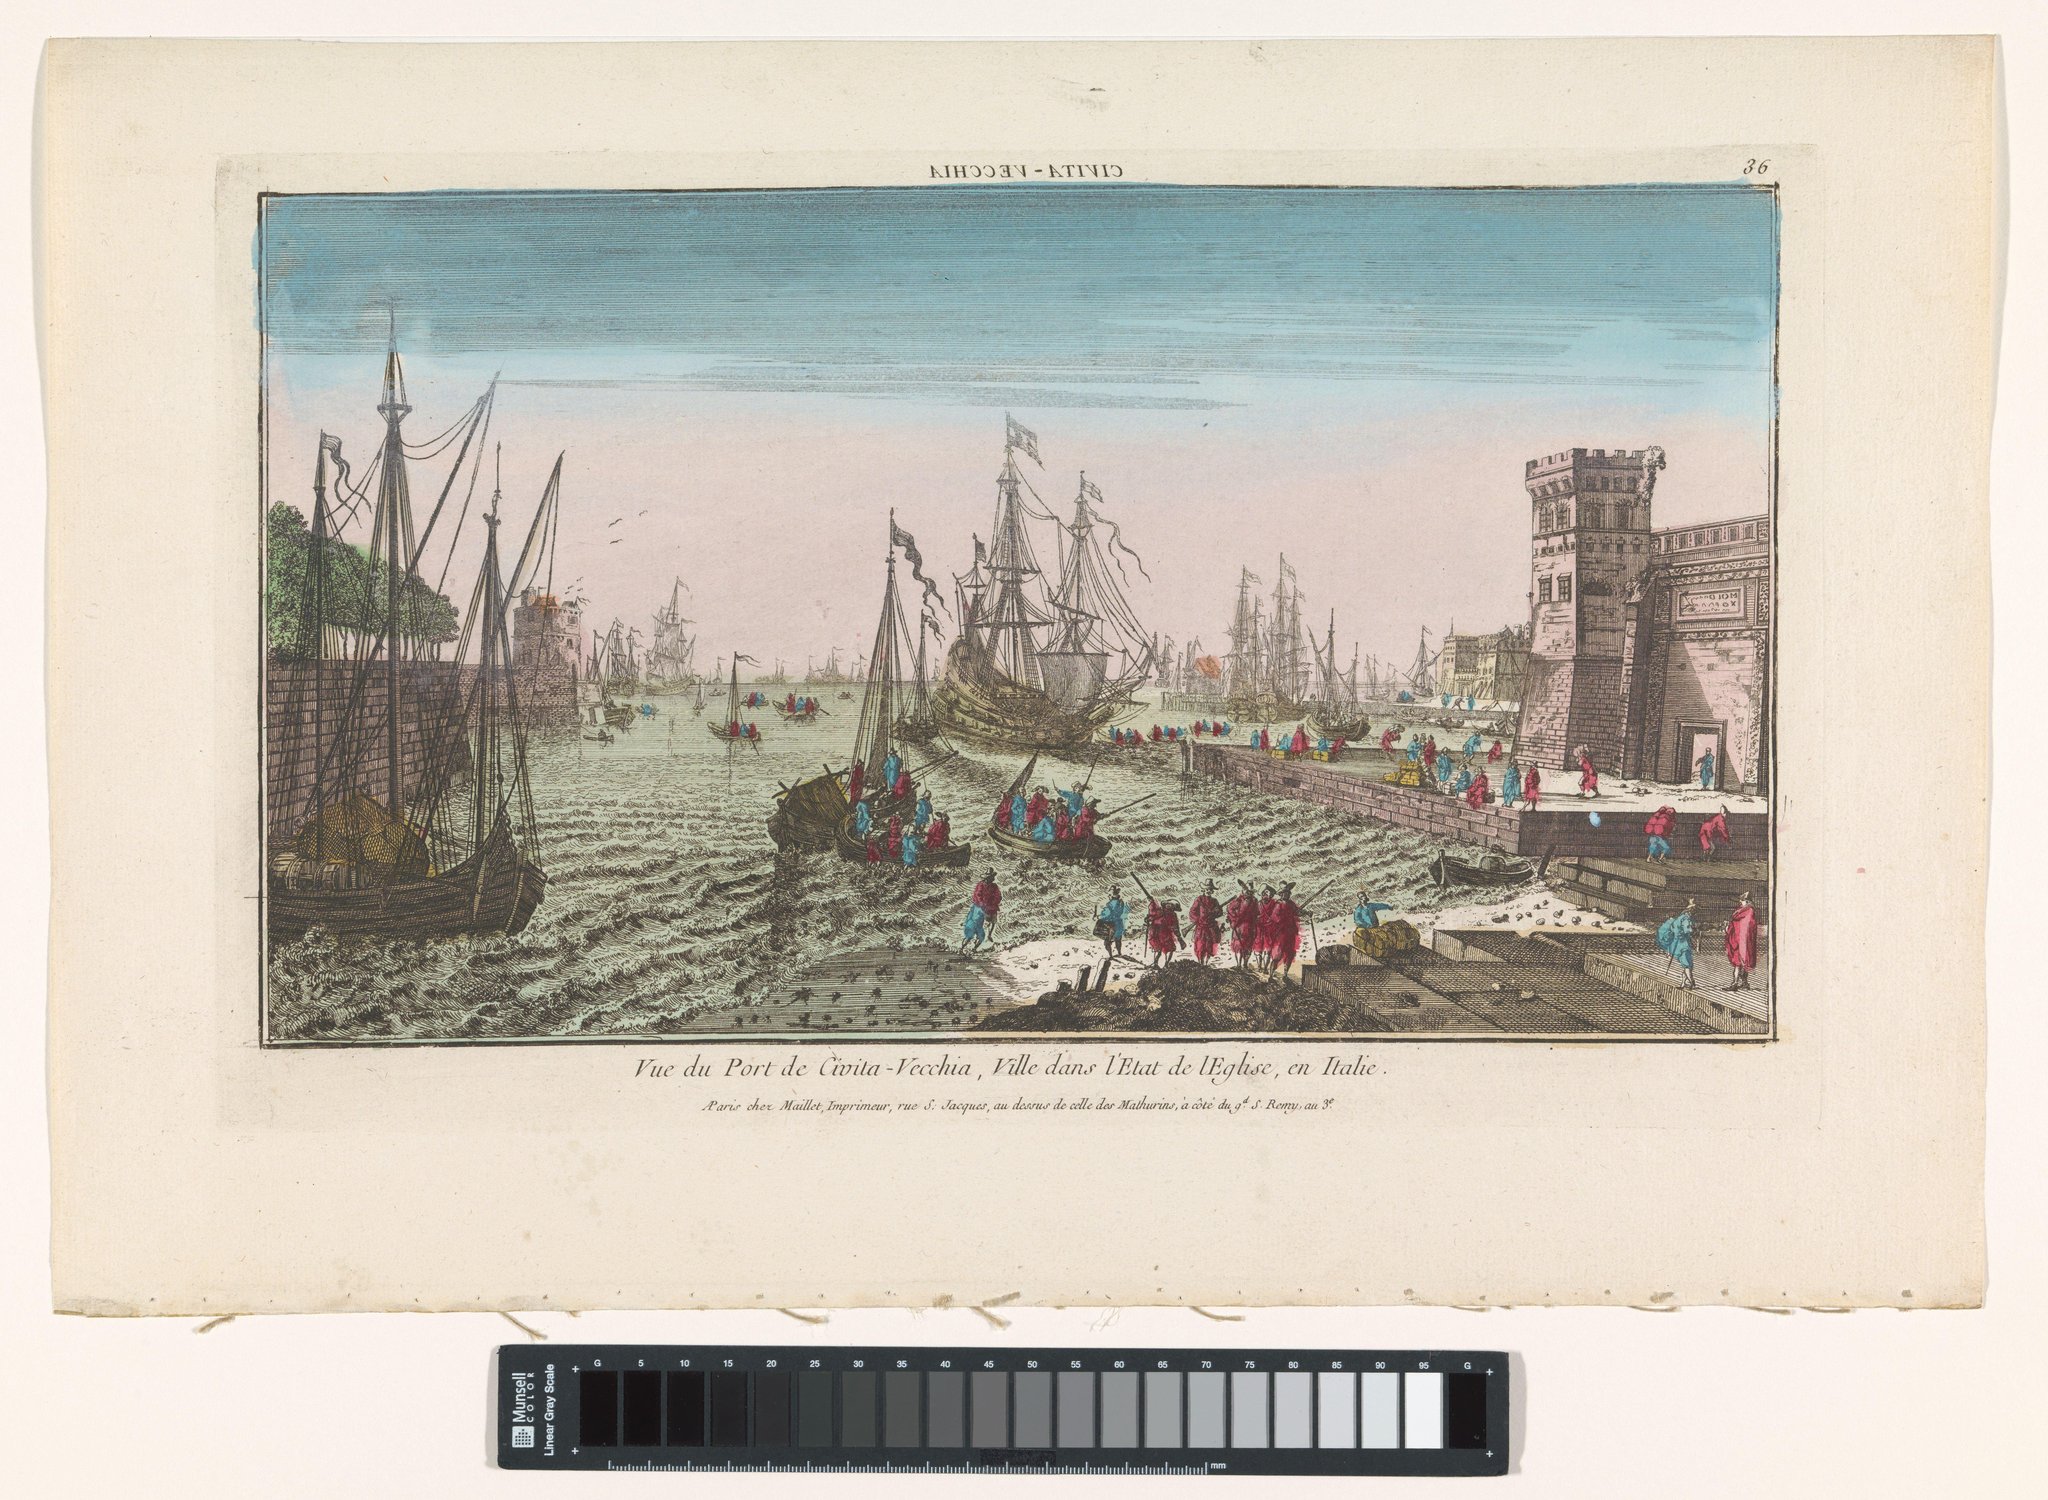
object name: print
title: Civita-Vecchia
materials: paper, watercolor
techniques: brush, etching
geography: paris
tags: harbour, sailing-ship, sailing-boat, rowing-boat, canoe, etc., sea (seascape) (+ landscape with figures, staffage), civic architecture; edifices; dwellings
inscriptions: collector's mark: Lugt 2166, watermark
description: Op het water liggen schepen en boten. Rechts staat een versterkt bouwwerk en groepen figuren met goederen aan de waterkant. Genummerd: 36.